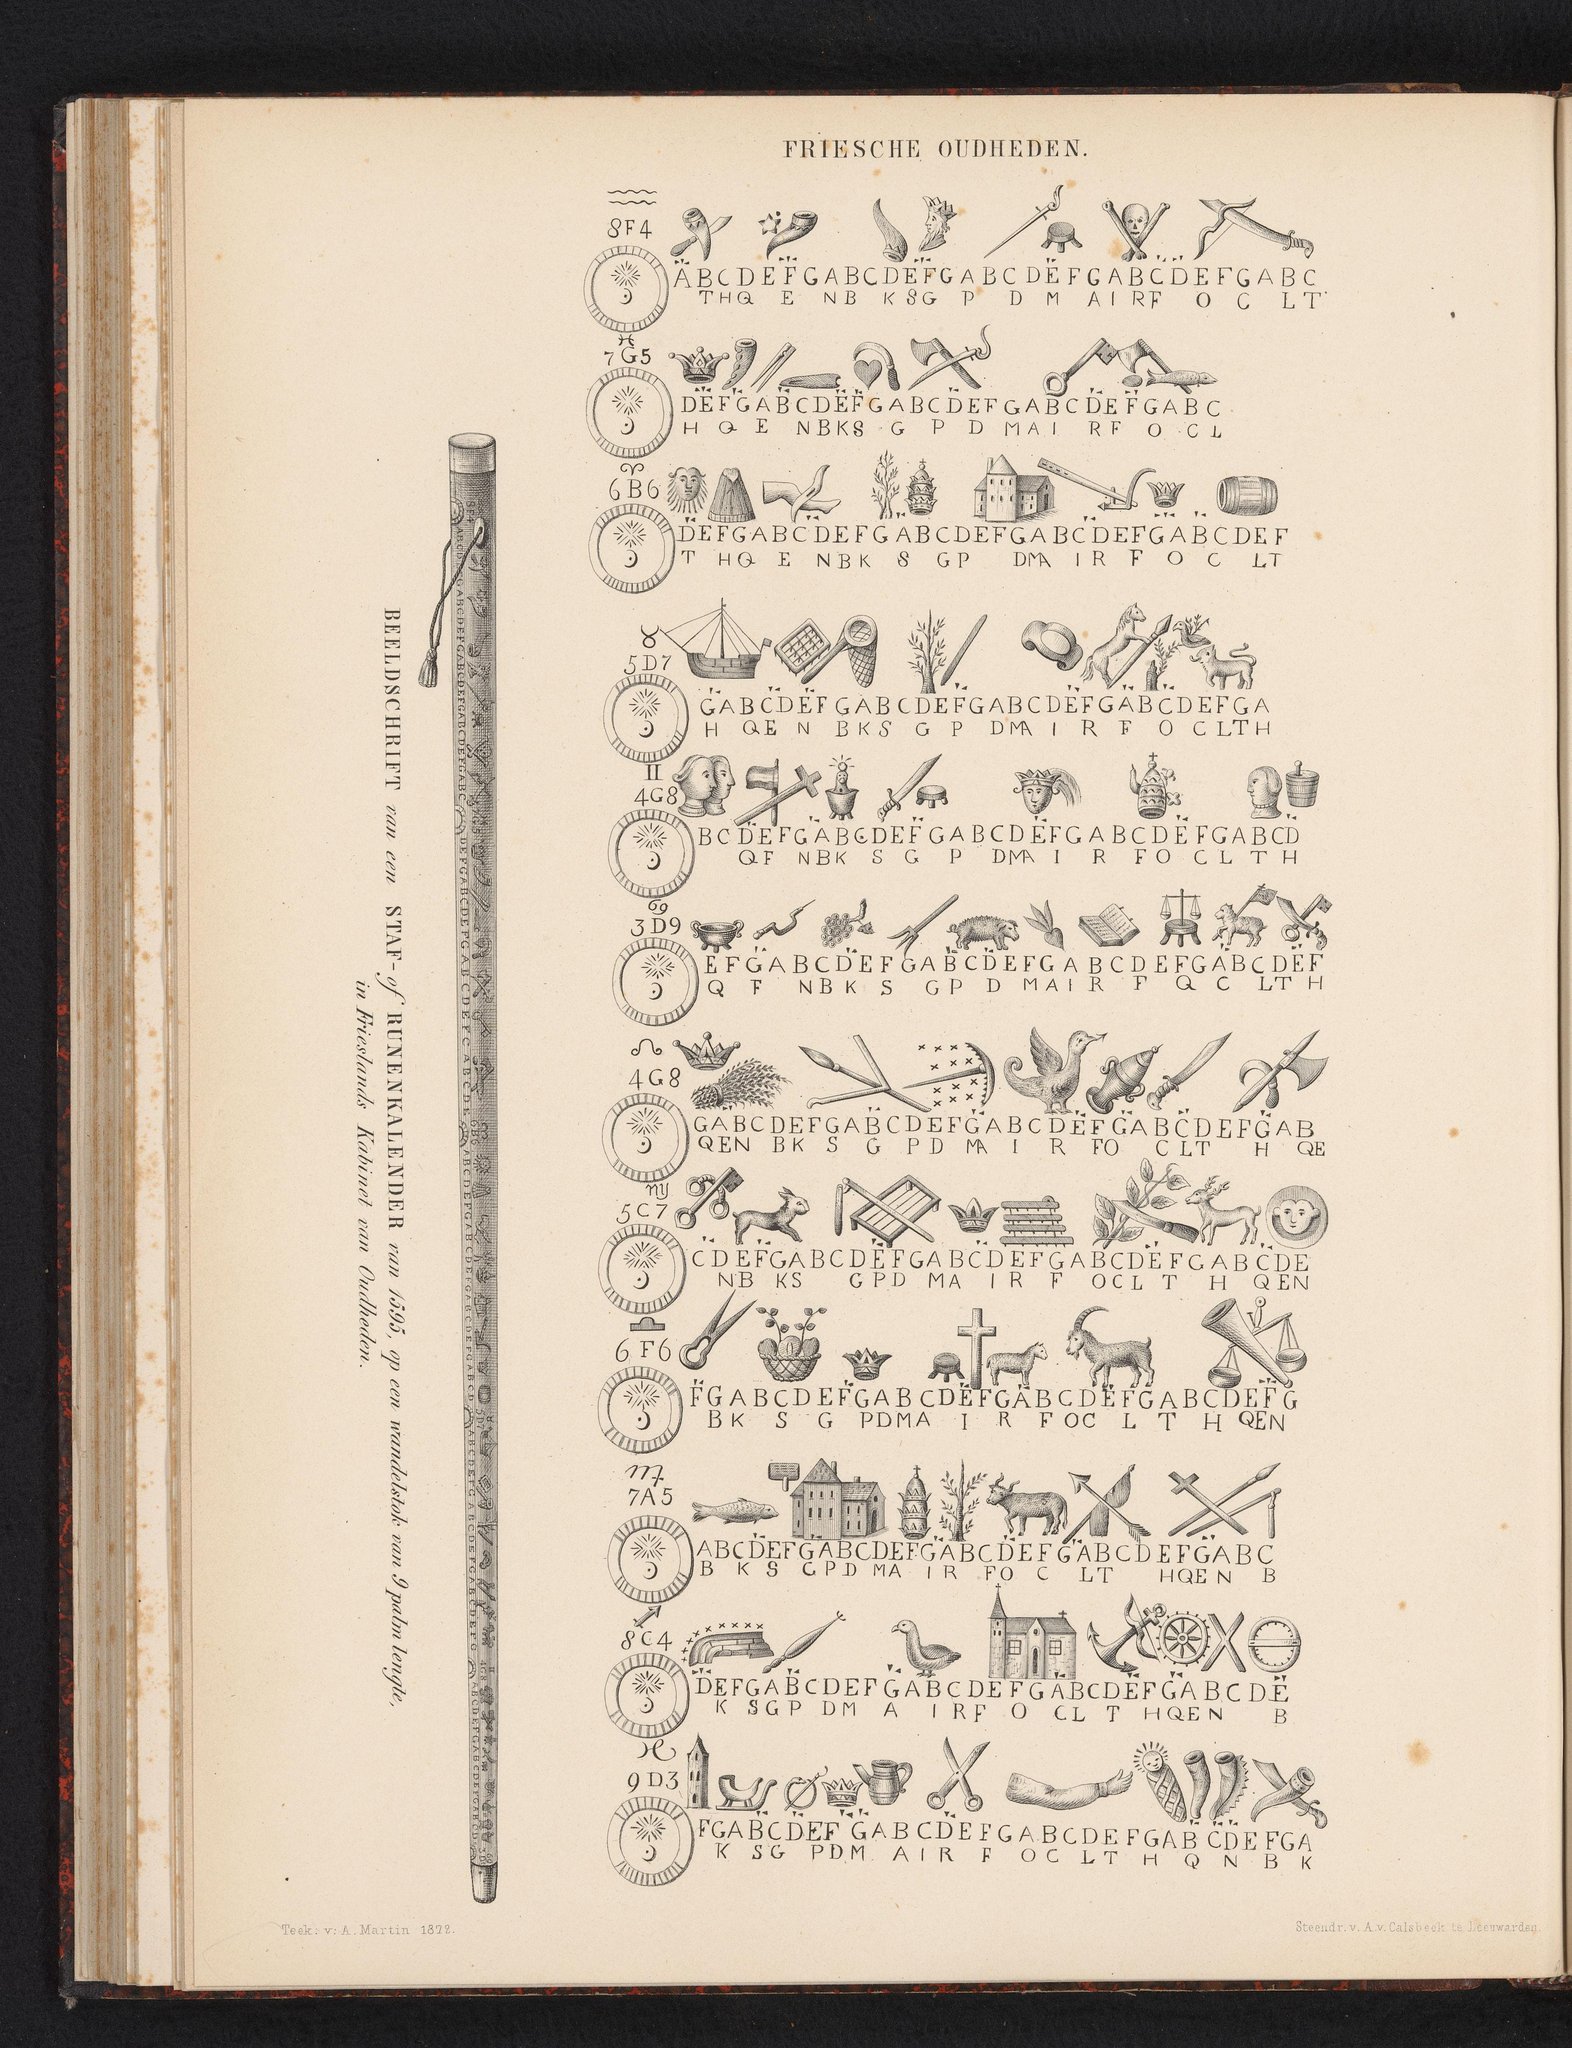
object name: print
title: Beeldschrift van een staf- of runenkalender van 1595, op een wandelstok van 9 palm lengte, in Frieslands Kabinet van Oudheden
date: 1872-1875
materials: paper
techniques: lithograph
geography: leeuwarden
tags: calendar, almanac, pictorial and ideographic script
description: Illustratie in: Friesche Oudheden. Afbeeldingen van merkwaardige voorwerpen van Wetenschap en Kunst, gevonden in de archieven, kerken, kasteelen, terpen enz. van Friesland, Leeuwarden 1875. Niet in Frederik Muller; door het RPK toegevoegd nummer.